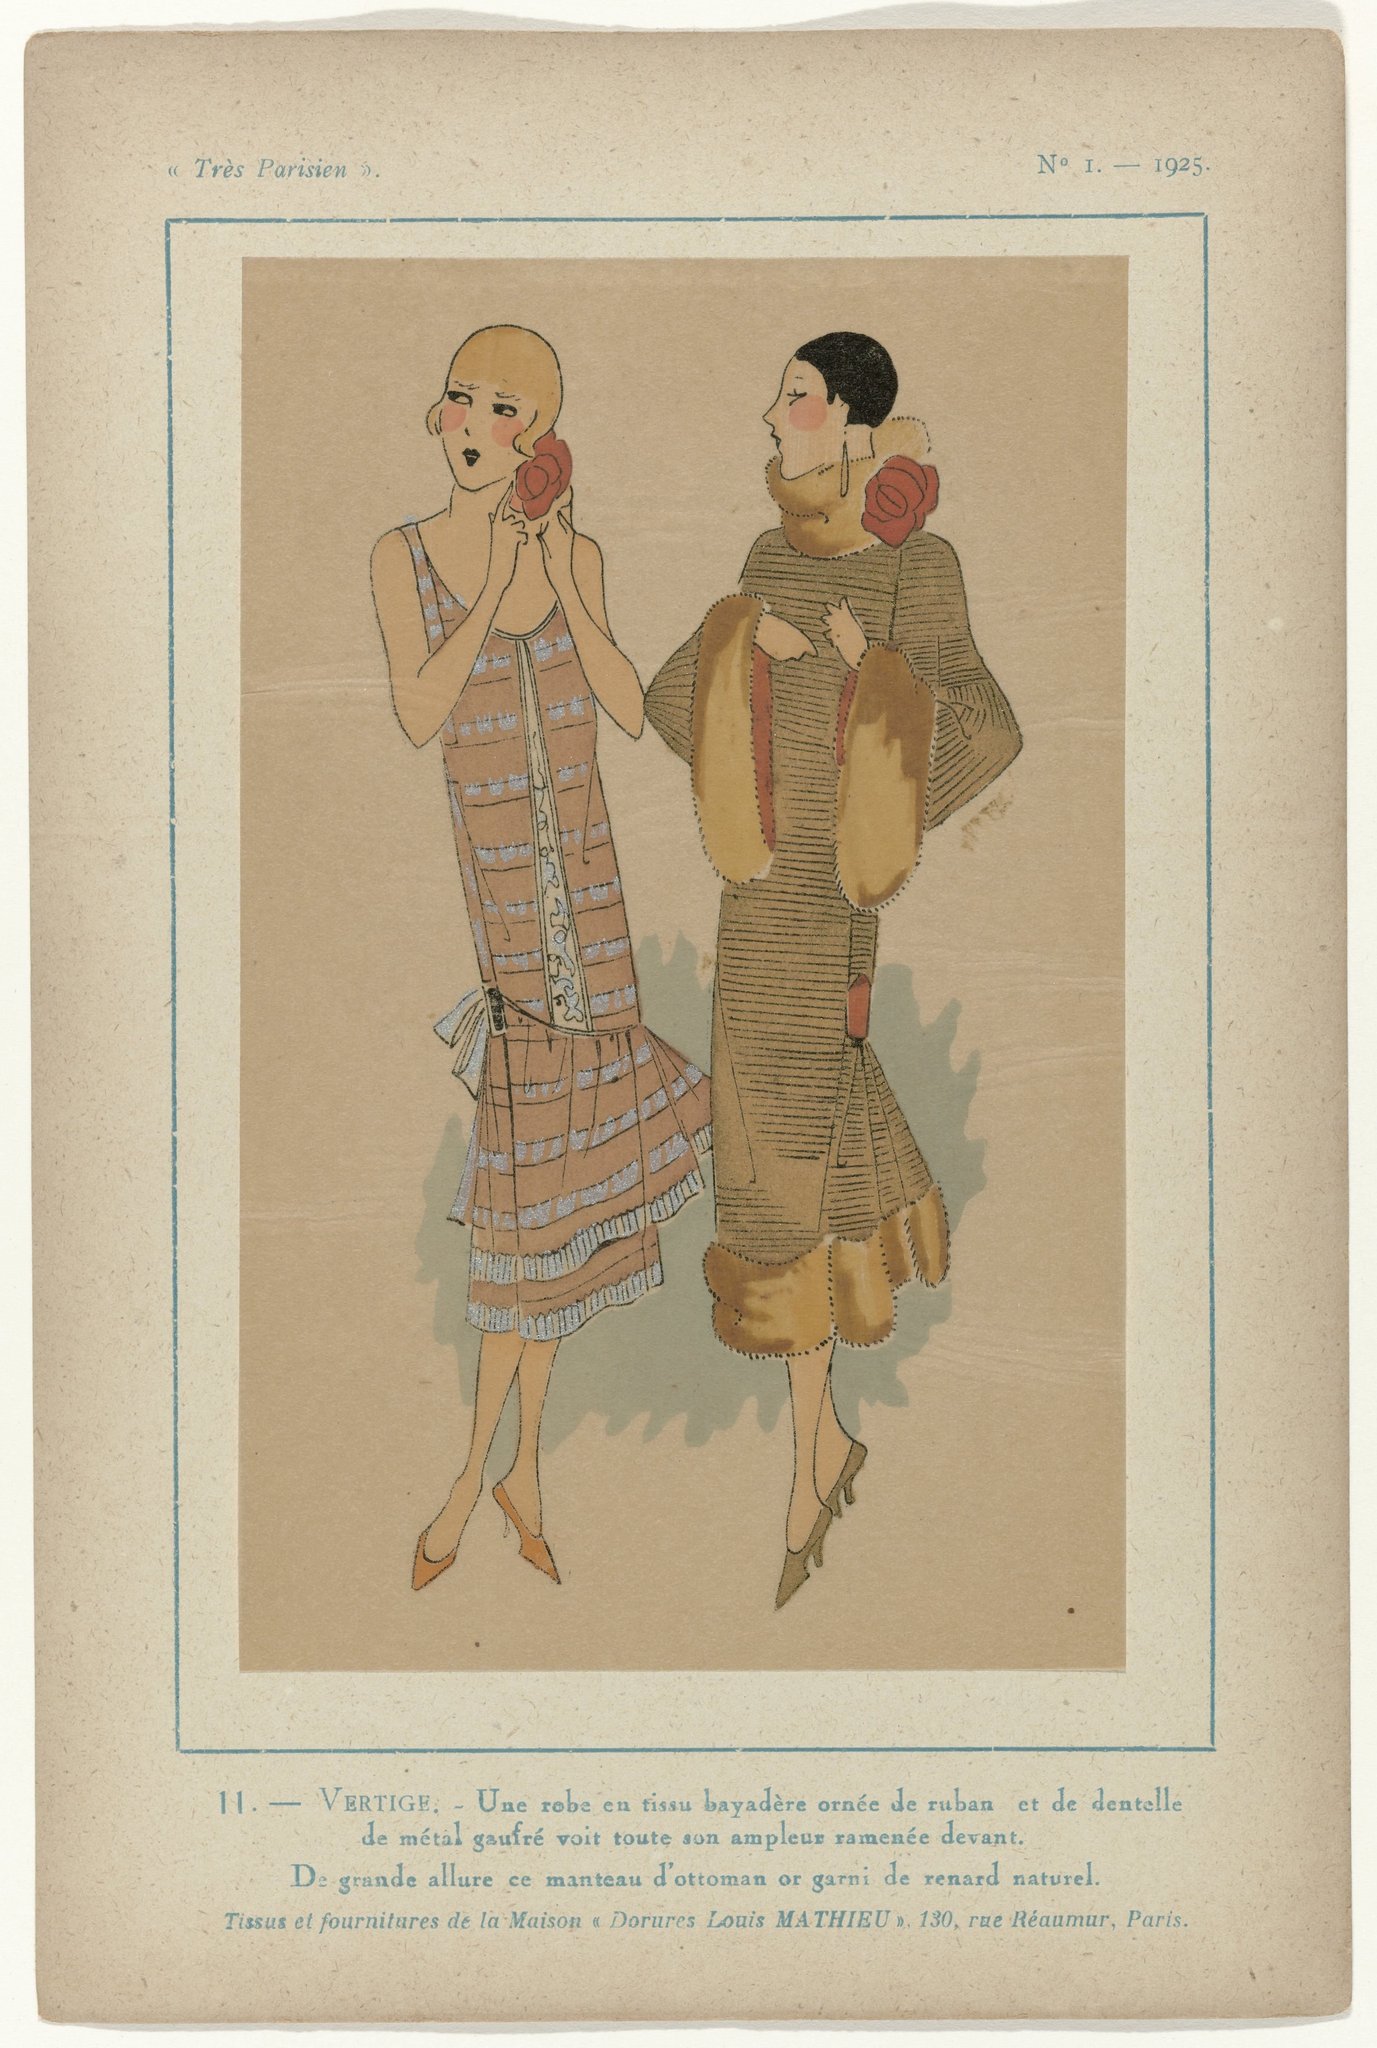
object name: fashion print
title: Très Parisien, 1925, No. 1, Pl. 11.-VERTIGE.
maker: g-p. joumard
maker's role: publisher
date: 1925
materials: paper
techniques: hand coloring, letterpress printing, lithography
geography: paris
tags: ear-rings (+ women's clothes), dress, gown: dinner dress (+ women's clothes), coat (+ fur used for clothes), coat (+ women's clothes), fashion plates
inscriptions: date: ‘VERTIGE. - Une robe en tissu bayadère ornée de ruban et de dentelle de métal gaufré voit toute son ampleur ramenée devant. De grande allure ce manteau d'ottoman or garni de renard naturel.’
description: Japon en bontmantel met stof van Maison "Dorures Louis Matthieu". Prent uit het modetijdschrift Très Parisien...La Mode, Le Chic, L'Élégance (1920-1936)